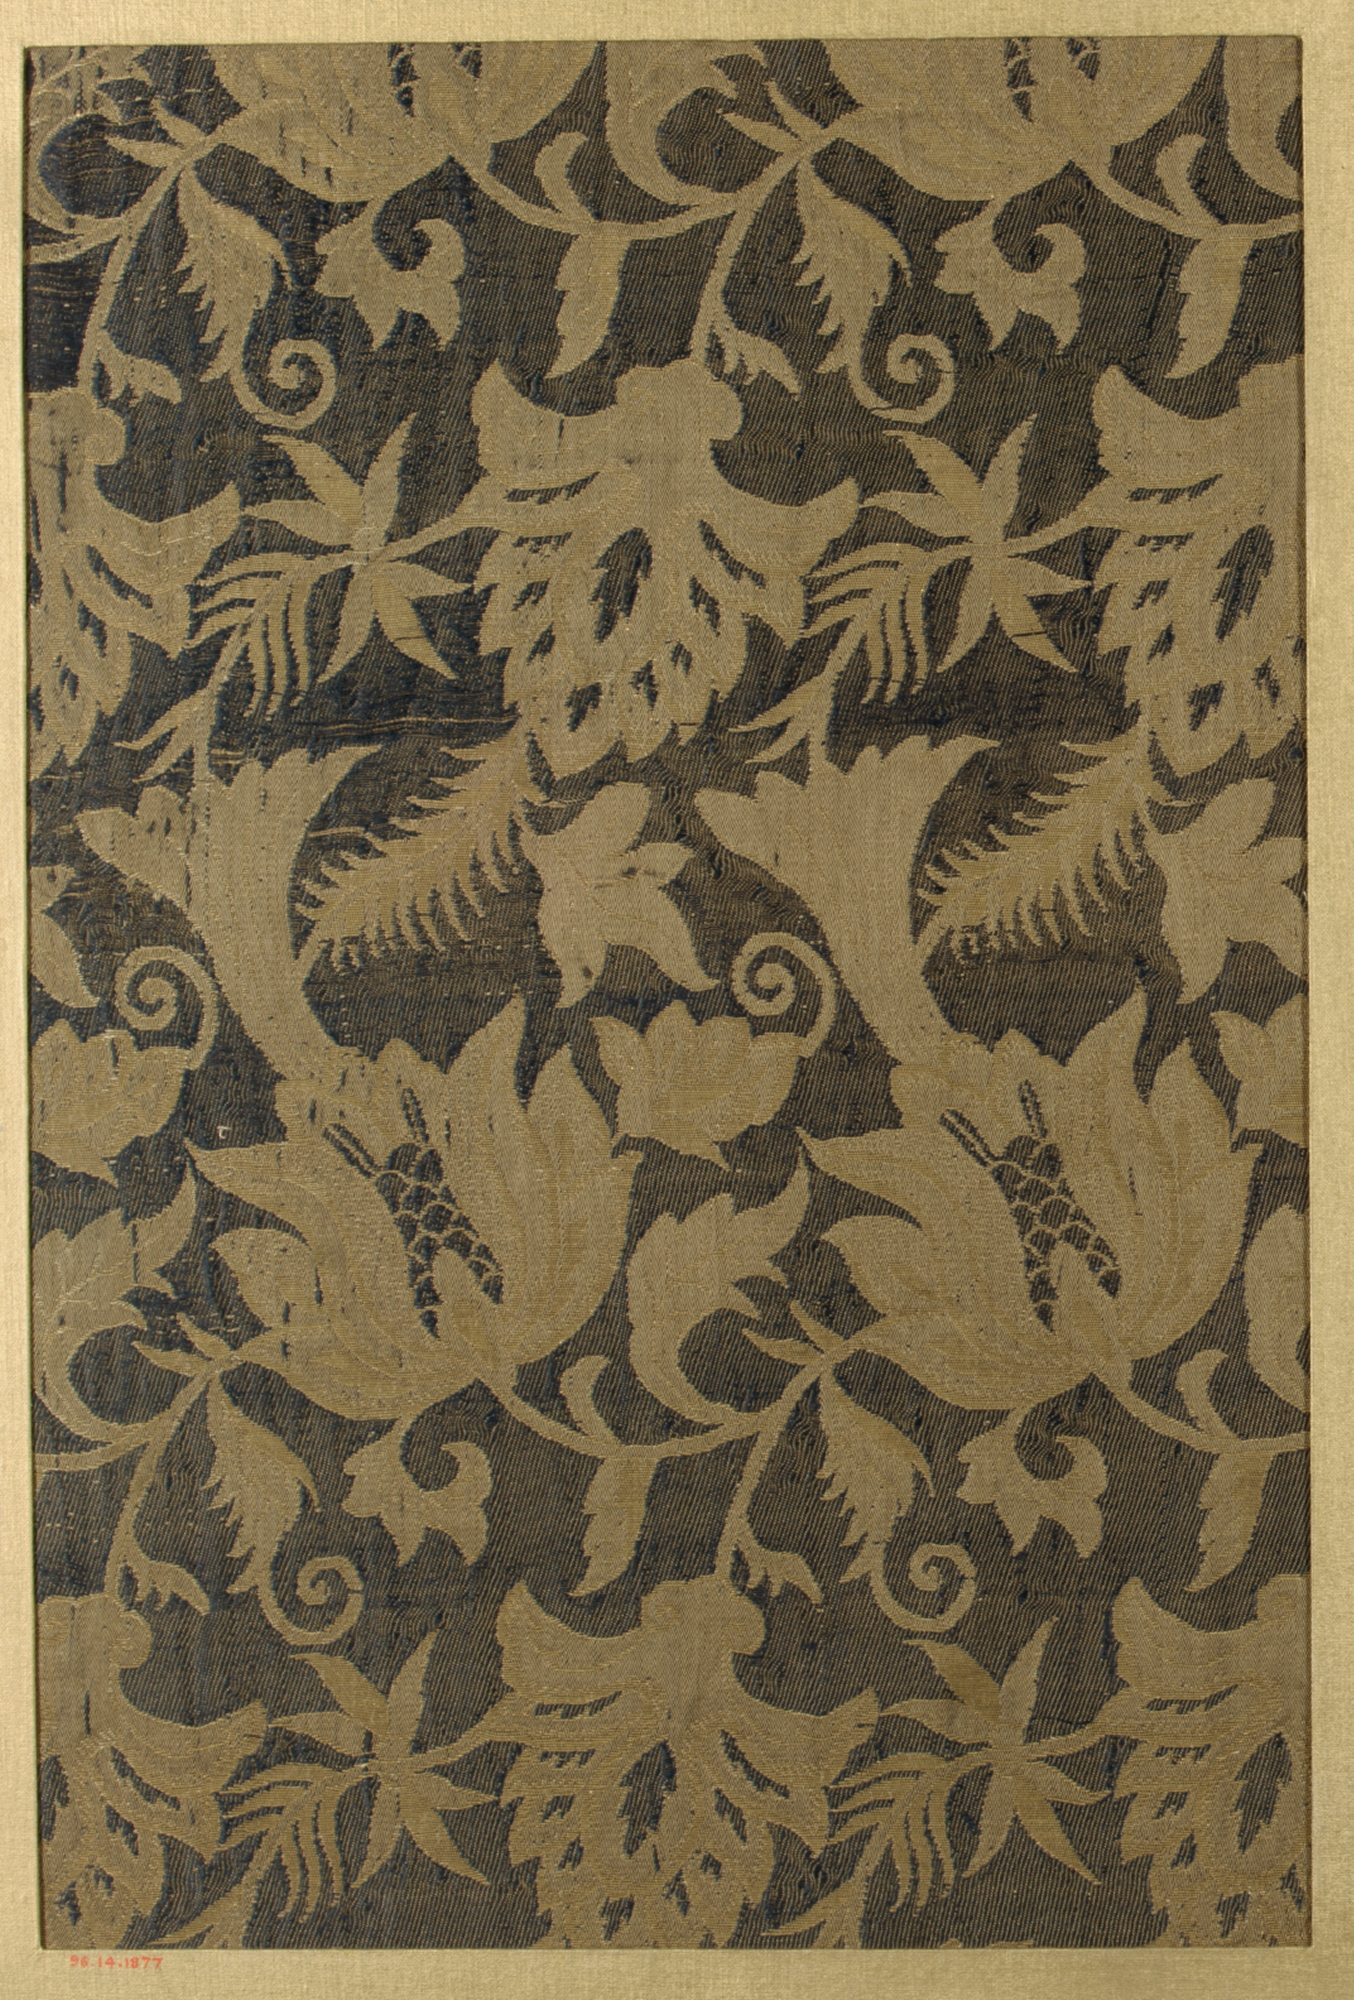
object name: piece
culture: japanese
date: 1701-1900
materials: silk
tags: leaves